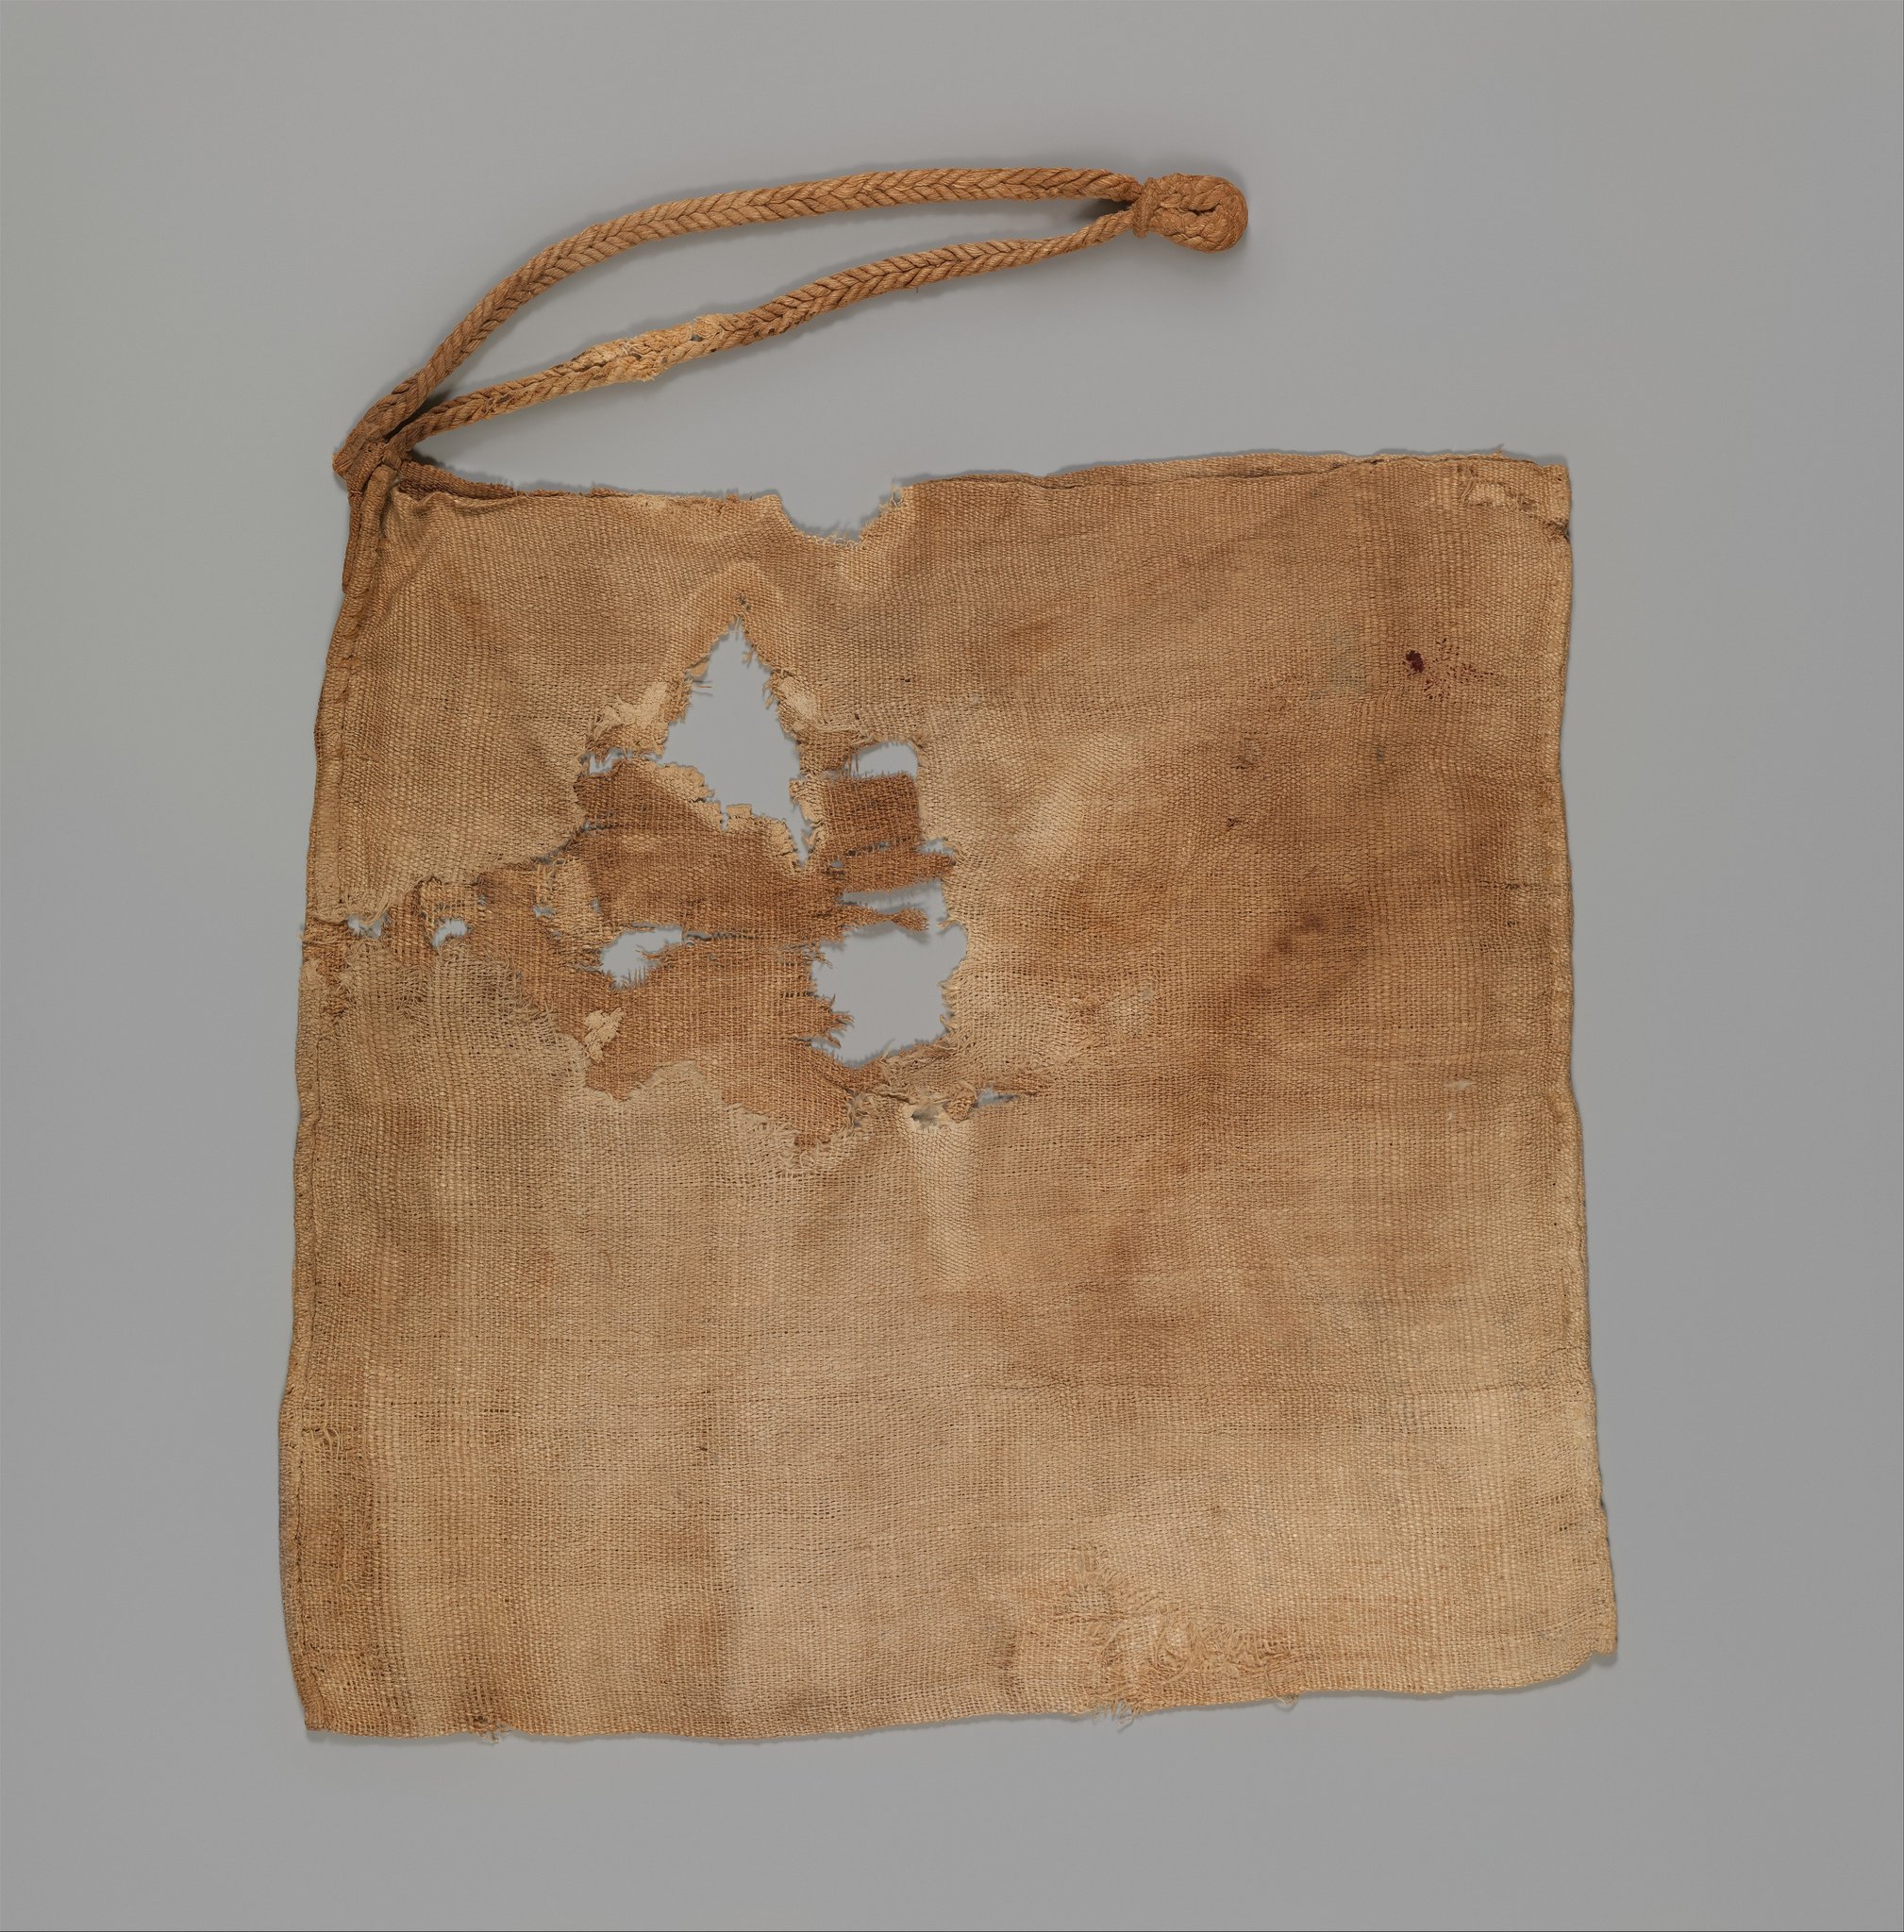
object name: bag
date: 601-700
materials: linen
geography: egypt